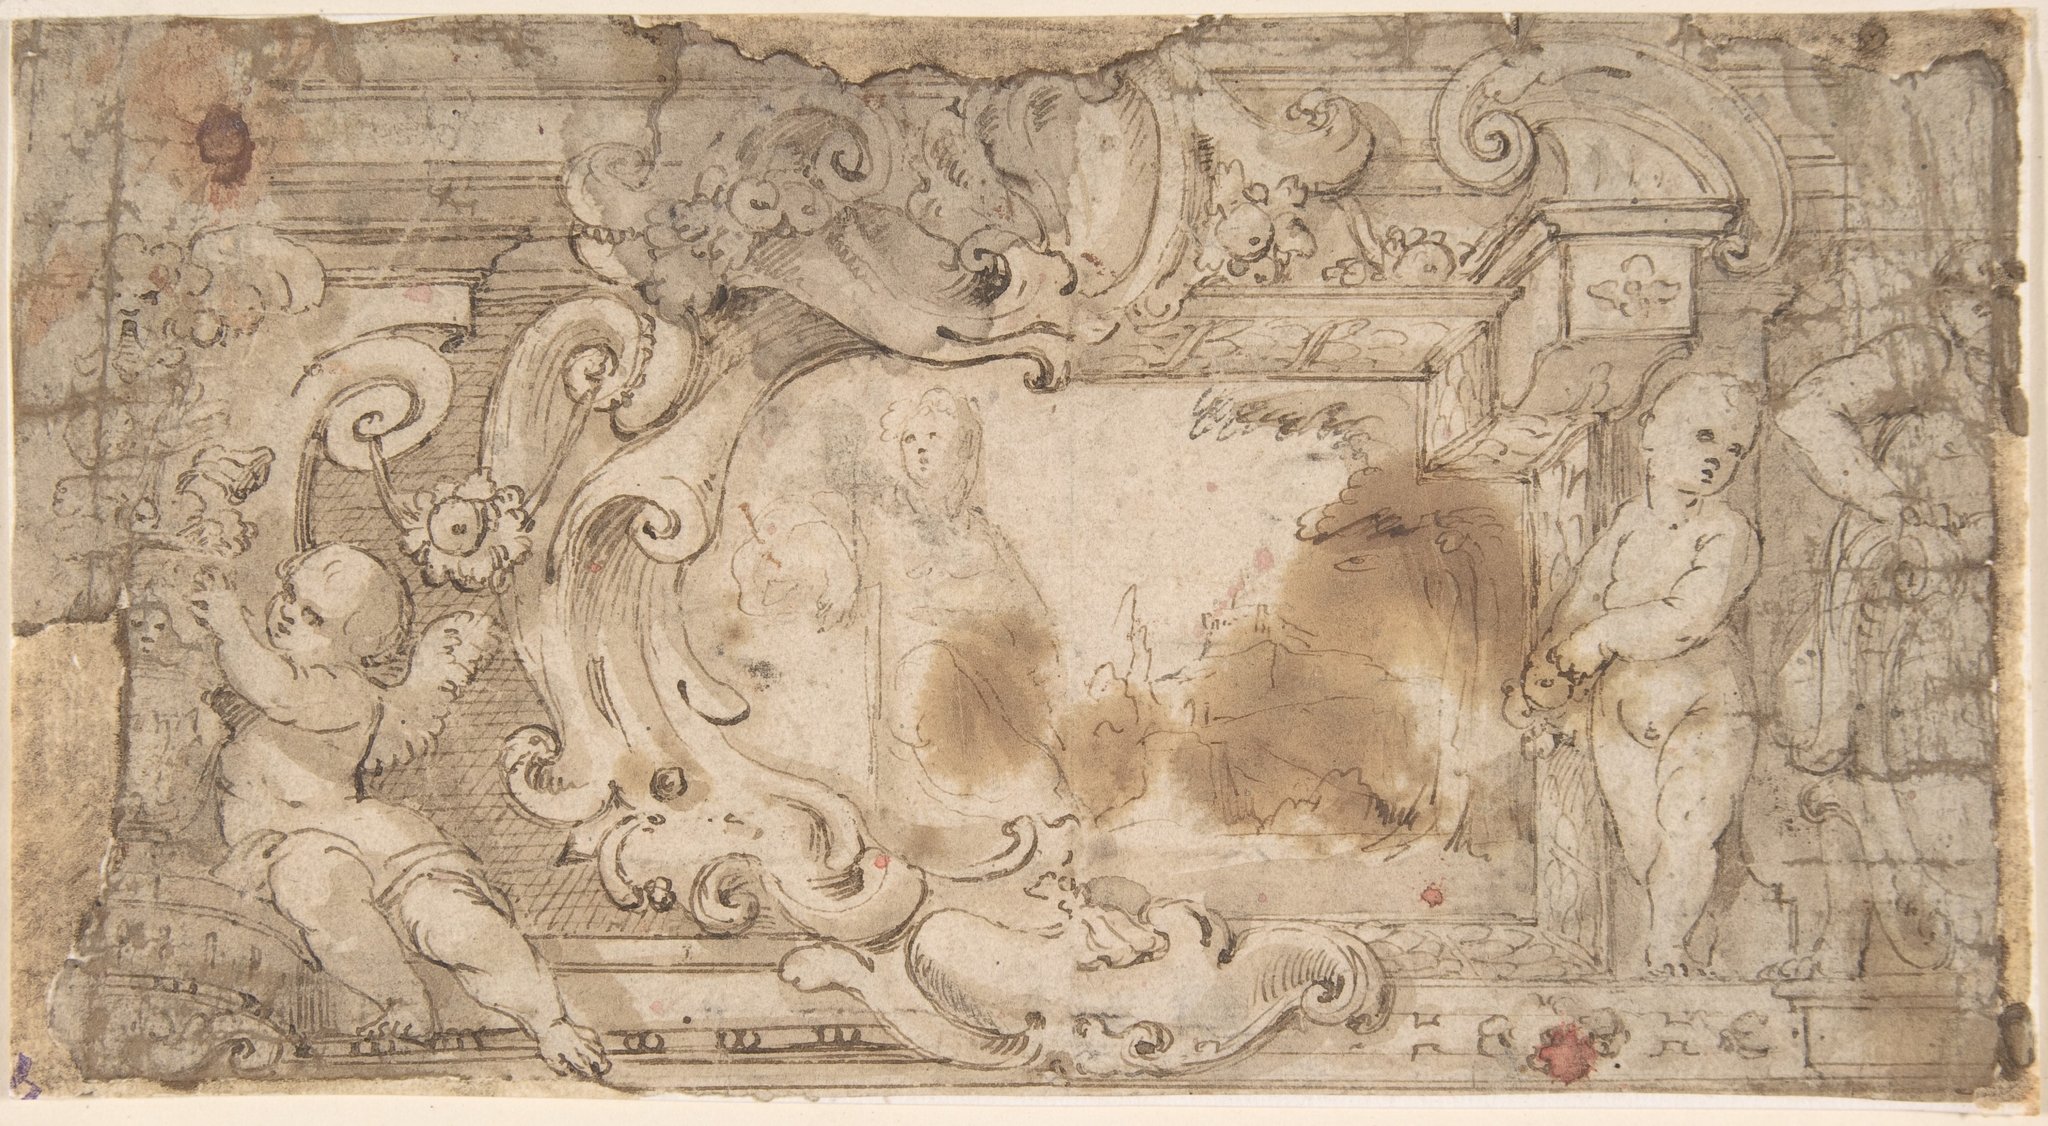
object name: drawing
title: Design for a Cartouche with a Variant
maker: anonymous, italian, 17th century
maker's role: artist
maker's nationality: italian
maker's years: 1600-1700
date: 1601-1700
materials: graphite, ink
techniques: brush, pen, wash